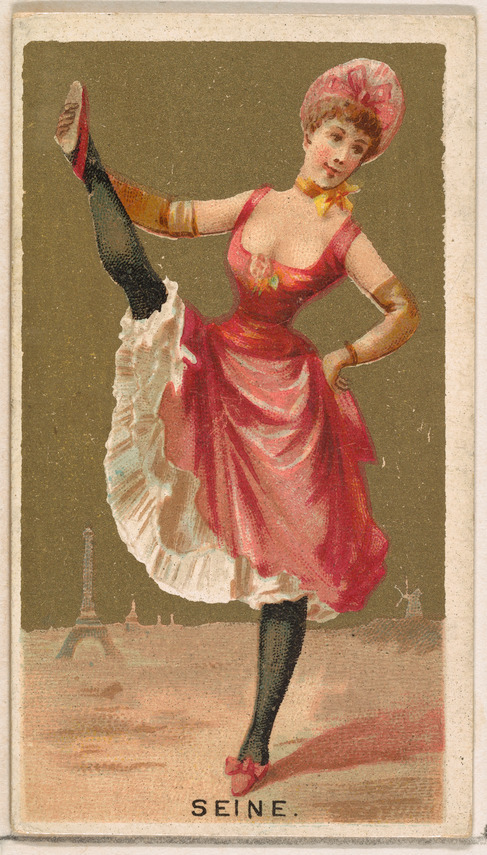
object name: print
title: Seine, from the Dancing Girls of the World series (N185) issued by Wm. S. Kimball & Co.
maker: william s. kimball & company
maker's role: publisher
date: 1889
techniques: color lithograph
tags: women,dancing,dancers